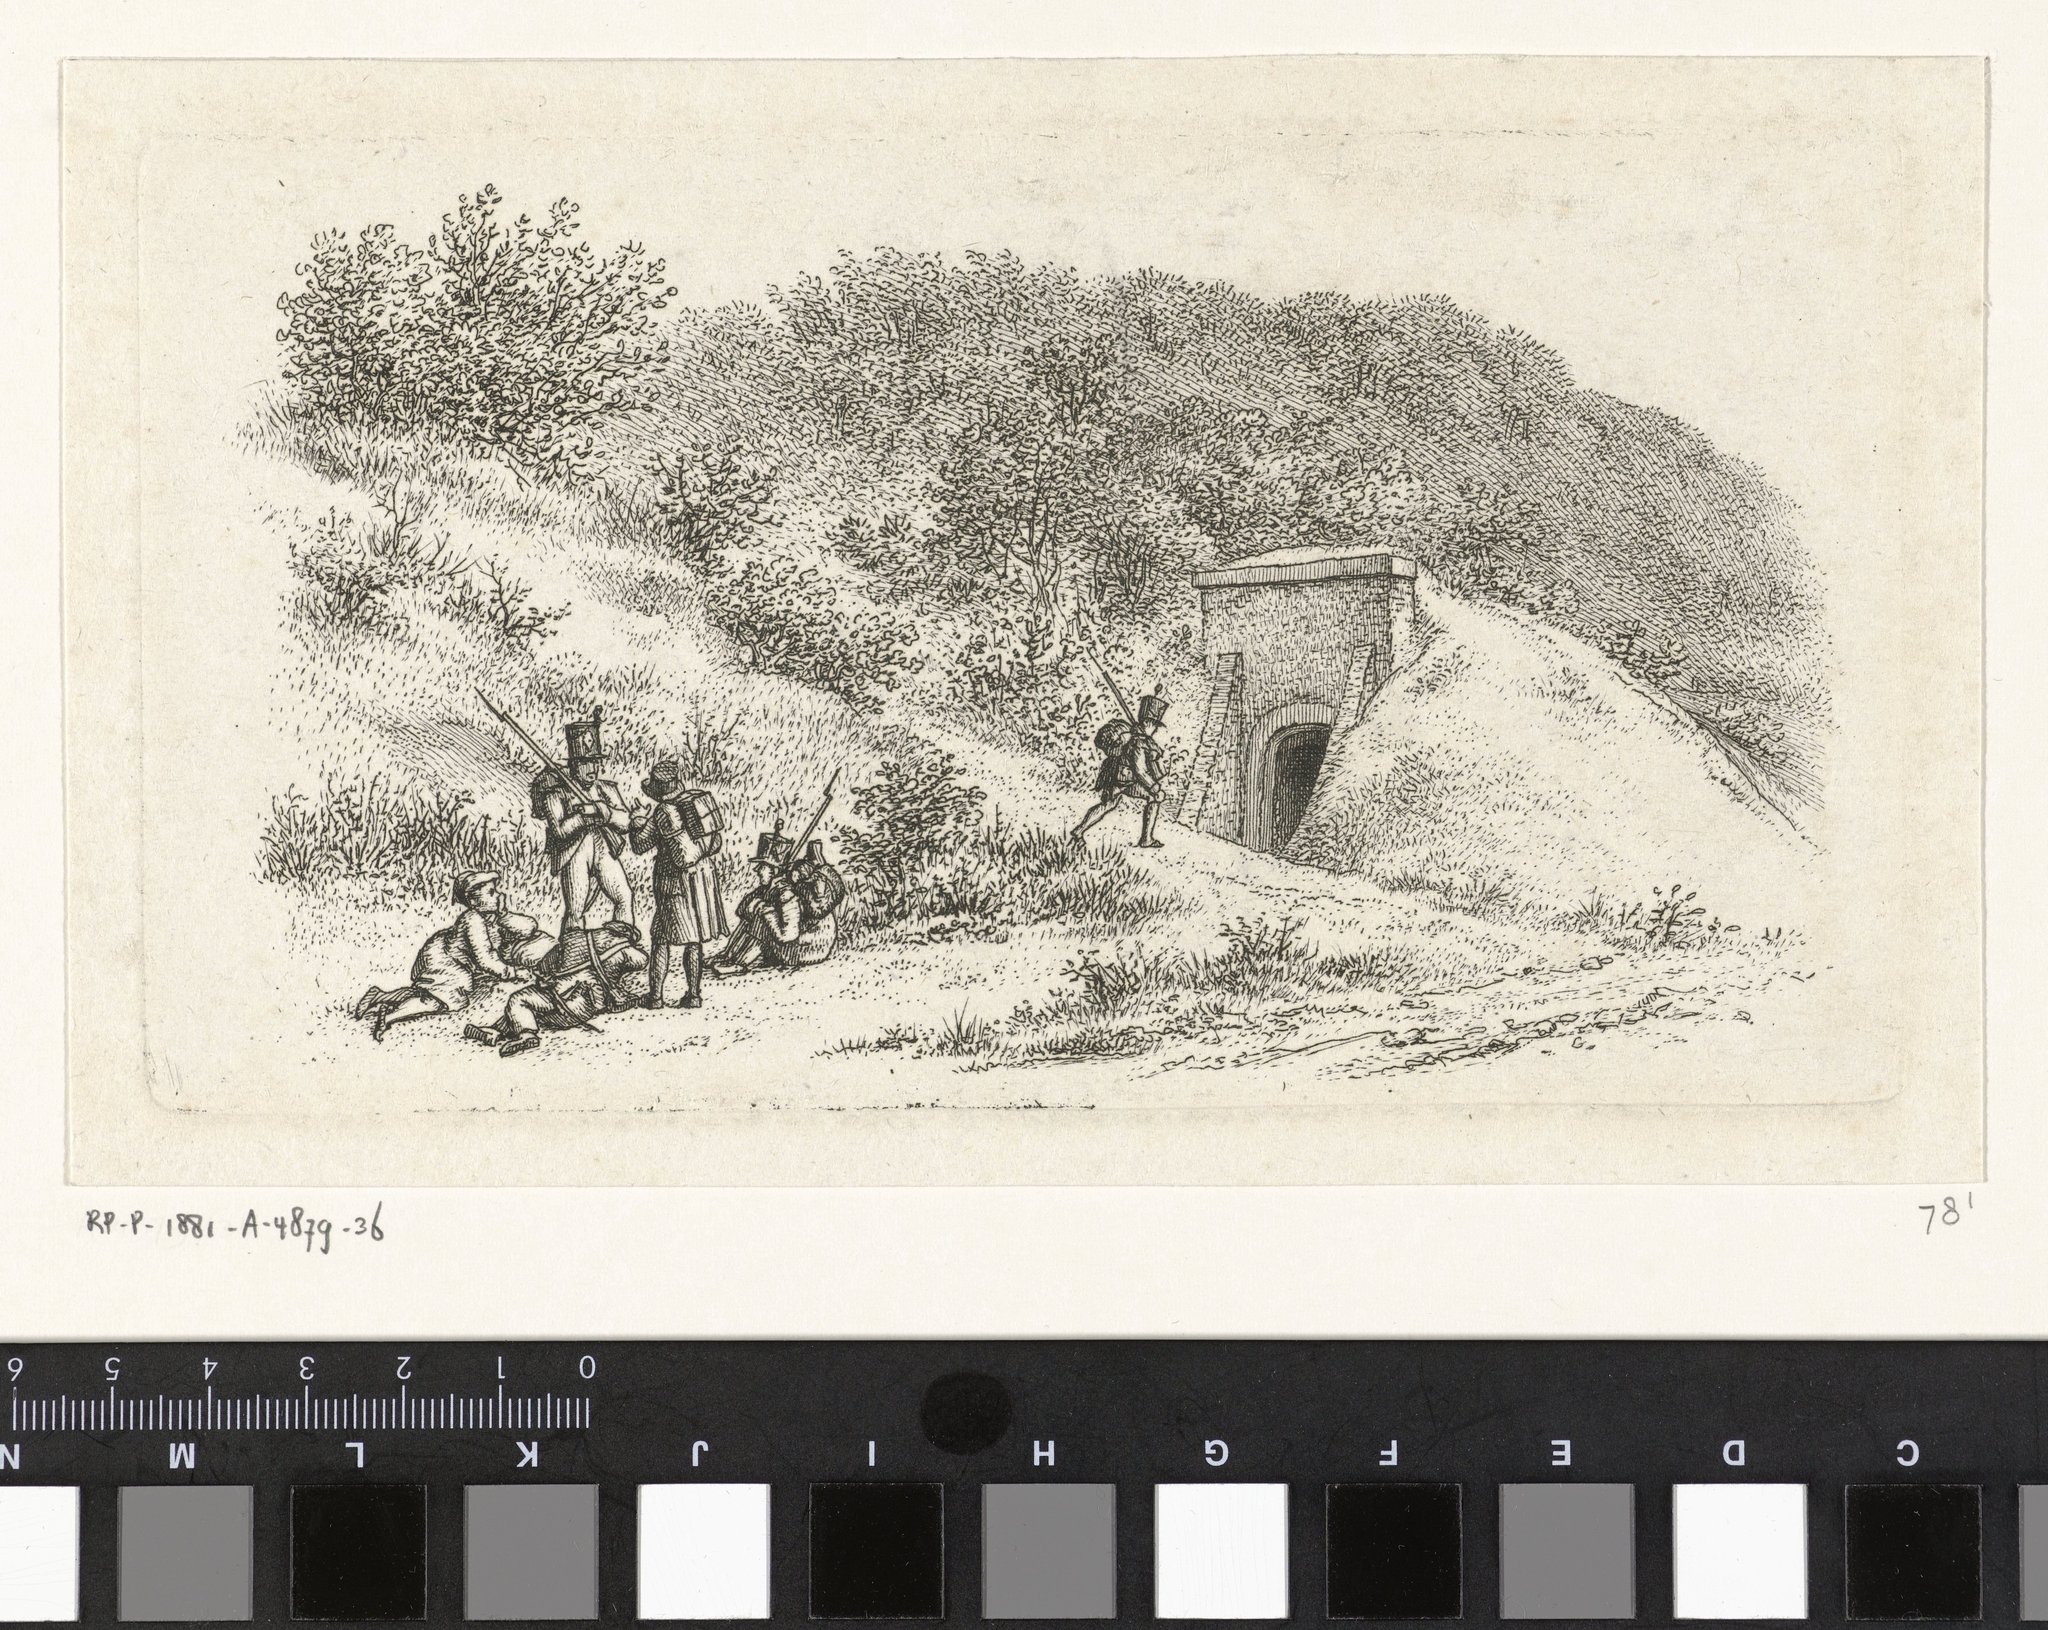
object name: print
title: Studie-prentwerk / Etudes gravées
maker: jacob ernst marcus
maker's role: draughtsman, print maker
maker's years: 1774-1826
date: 1804-1814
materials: paper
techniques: etching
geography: amsterdam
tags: the soldier; the soldier's life (+ outside city-wall or fortress)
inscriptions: collector's mark: Lugt 2228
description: Serie voor het eerst uitgegeven door Jacob Ernst Marcus onder de titel Studiebeelden en Fragmenten. Amsterdam: ca.1816. Later heruitgegeven als: Studie-prentwerk/ Etudes gravées.